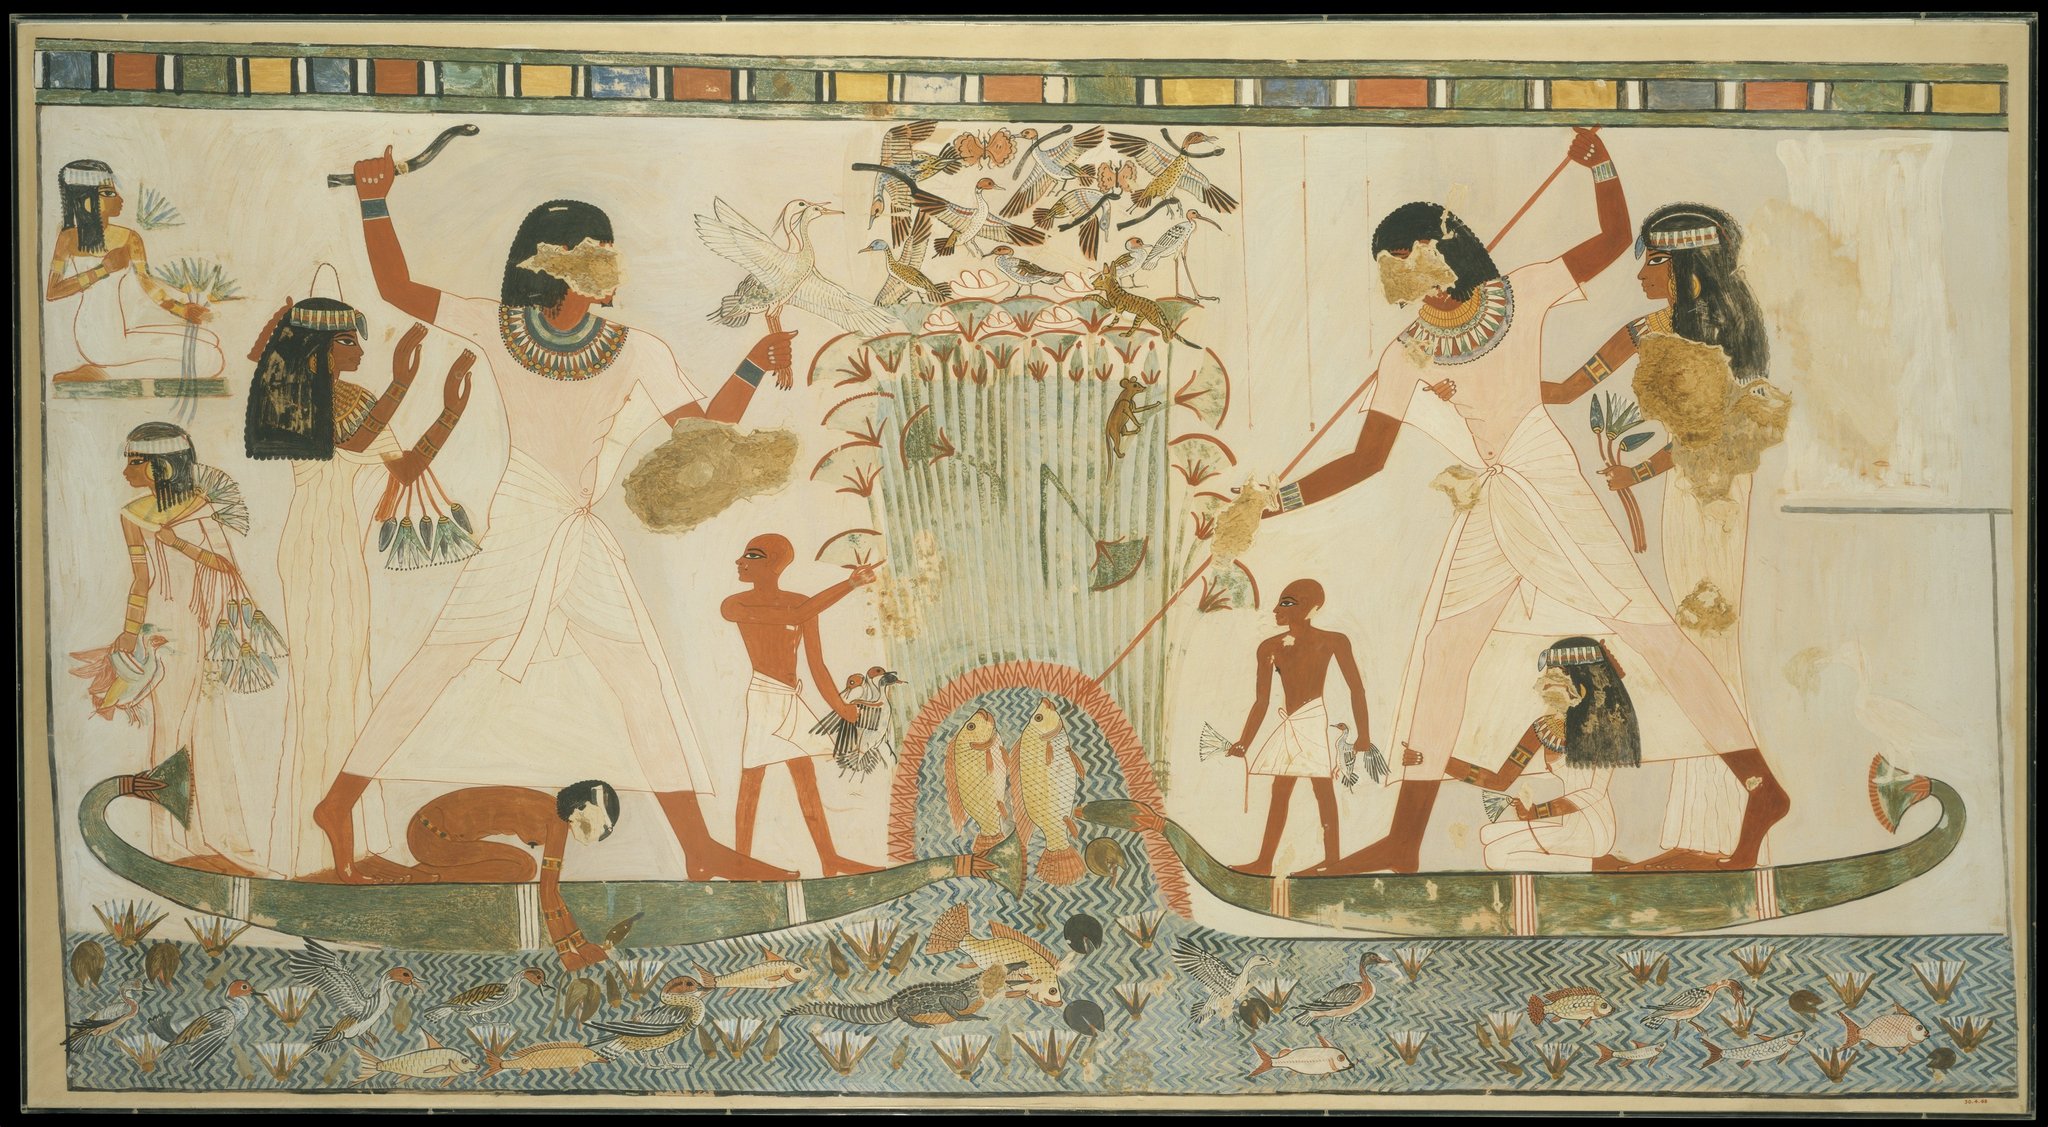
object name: facsimile, menna tt 69, marsh hunting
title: Menna and Family Hunting in the Marshes, Tomb of Menna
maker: nina de garis davies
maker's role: artist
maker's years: 1881-1965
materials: paper, paint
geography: egypt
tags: birds,men,women,hunting,crocodiles,fish,family,boats